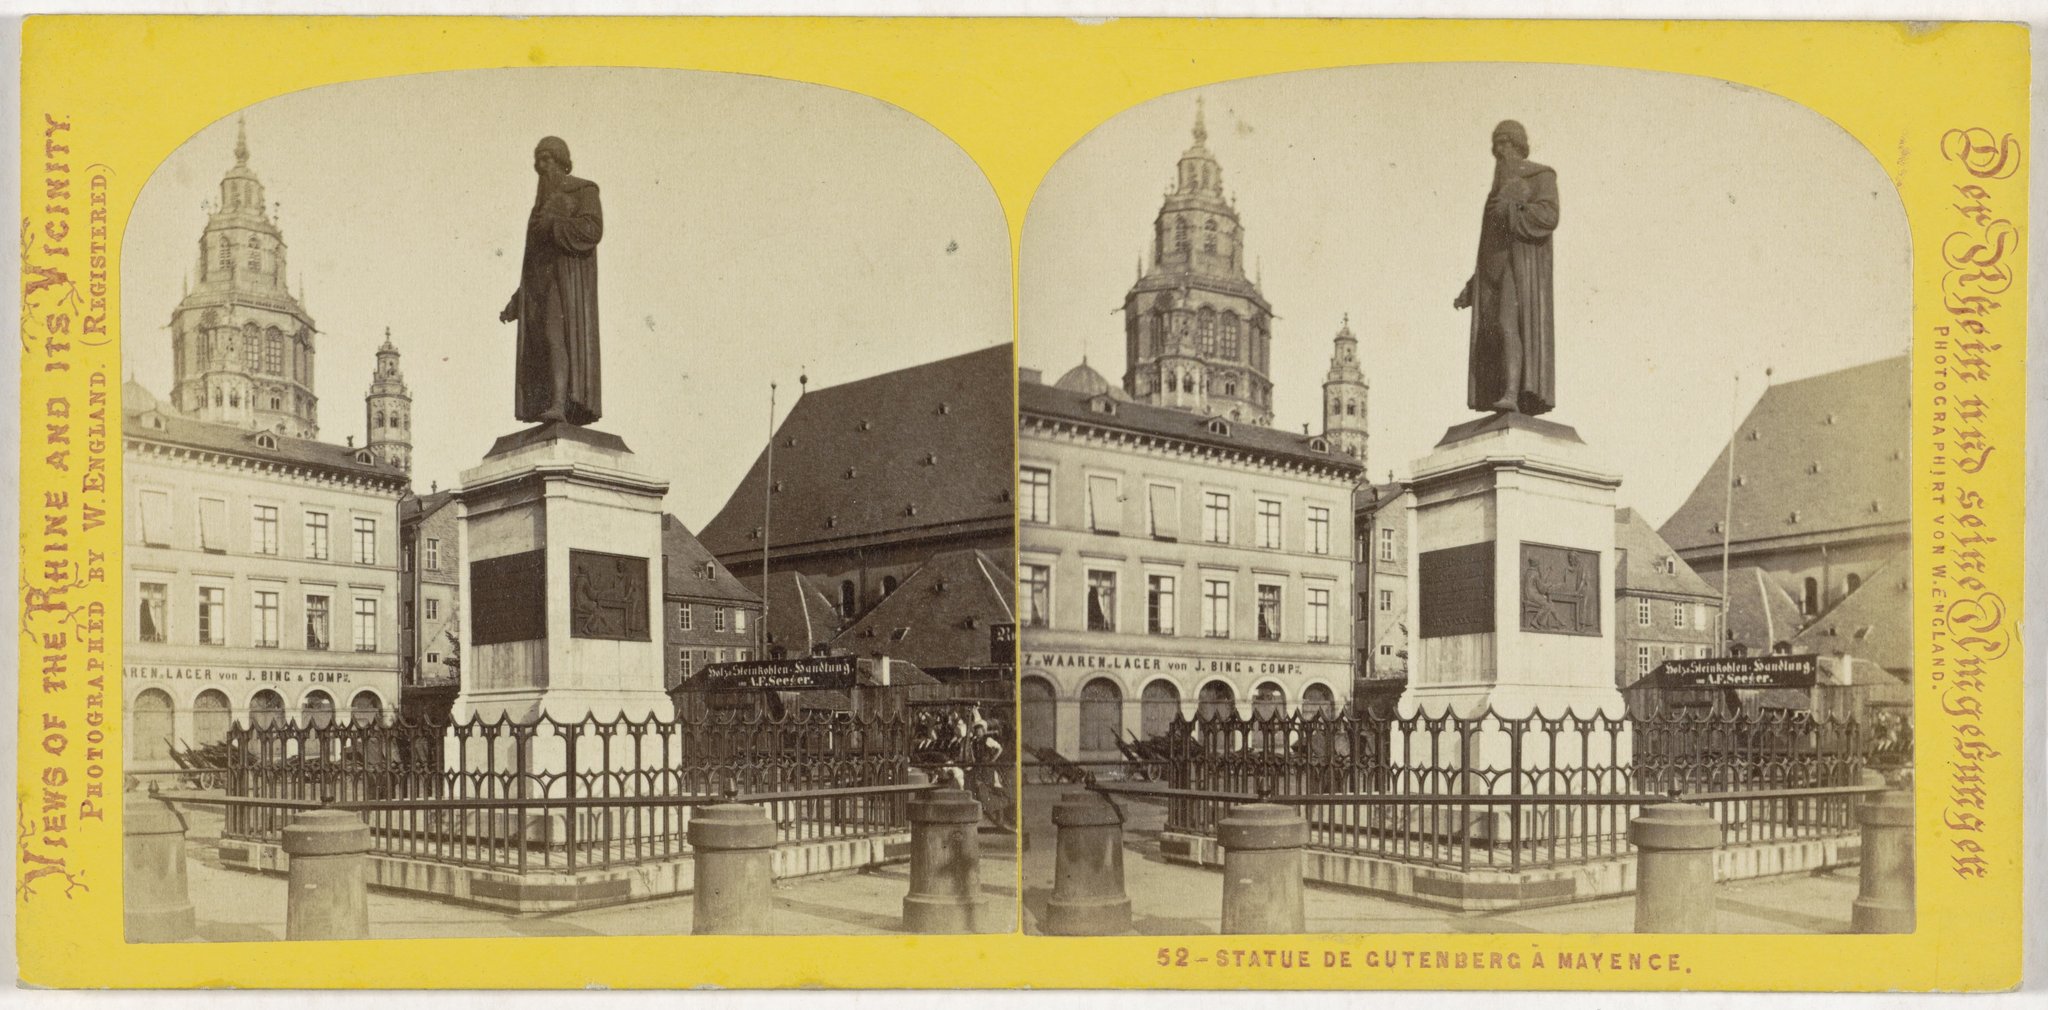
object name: stereograph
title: Standbeeld van Gutenberg in Mainz, Duitsland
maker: william england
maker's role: fotograaf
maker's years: 1816-1896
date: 1867-1868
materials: cardboard, paper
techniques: albumen print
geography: mainz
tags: printer, johannes gutenberg, urban housing, monument, statue, parts of church exterior and annexes: tower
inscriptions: inscription: ‘(Registered)’, number: ‘52’